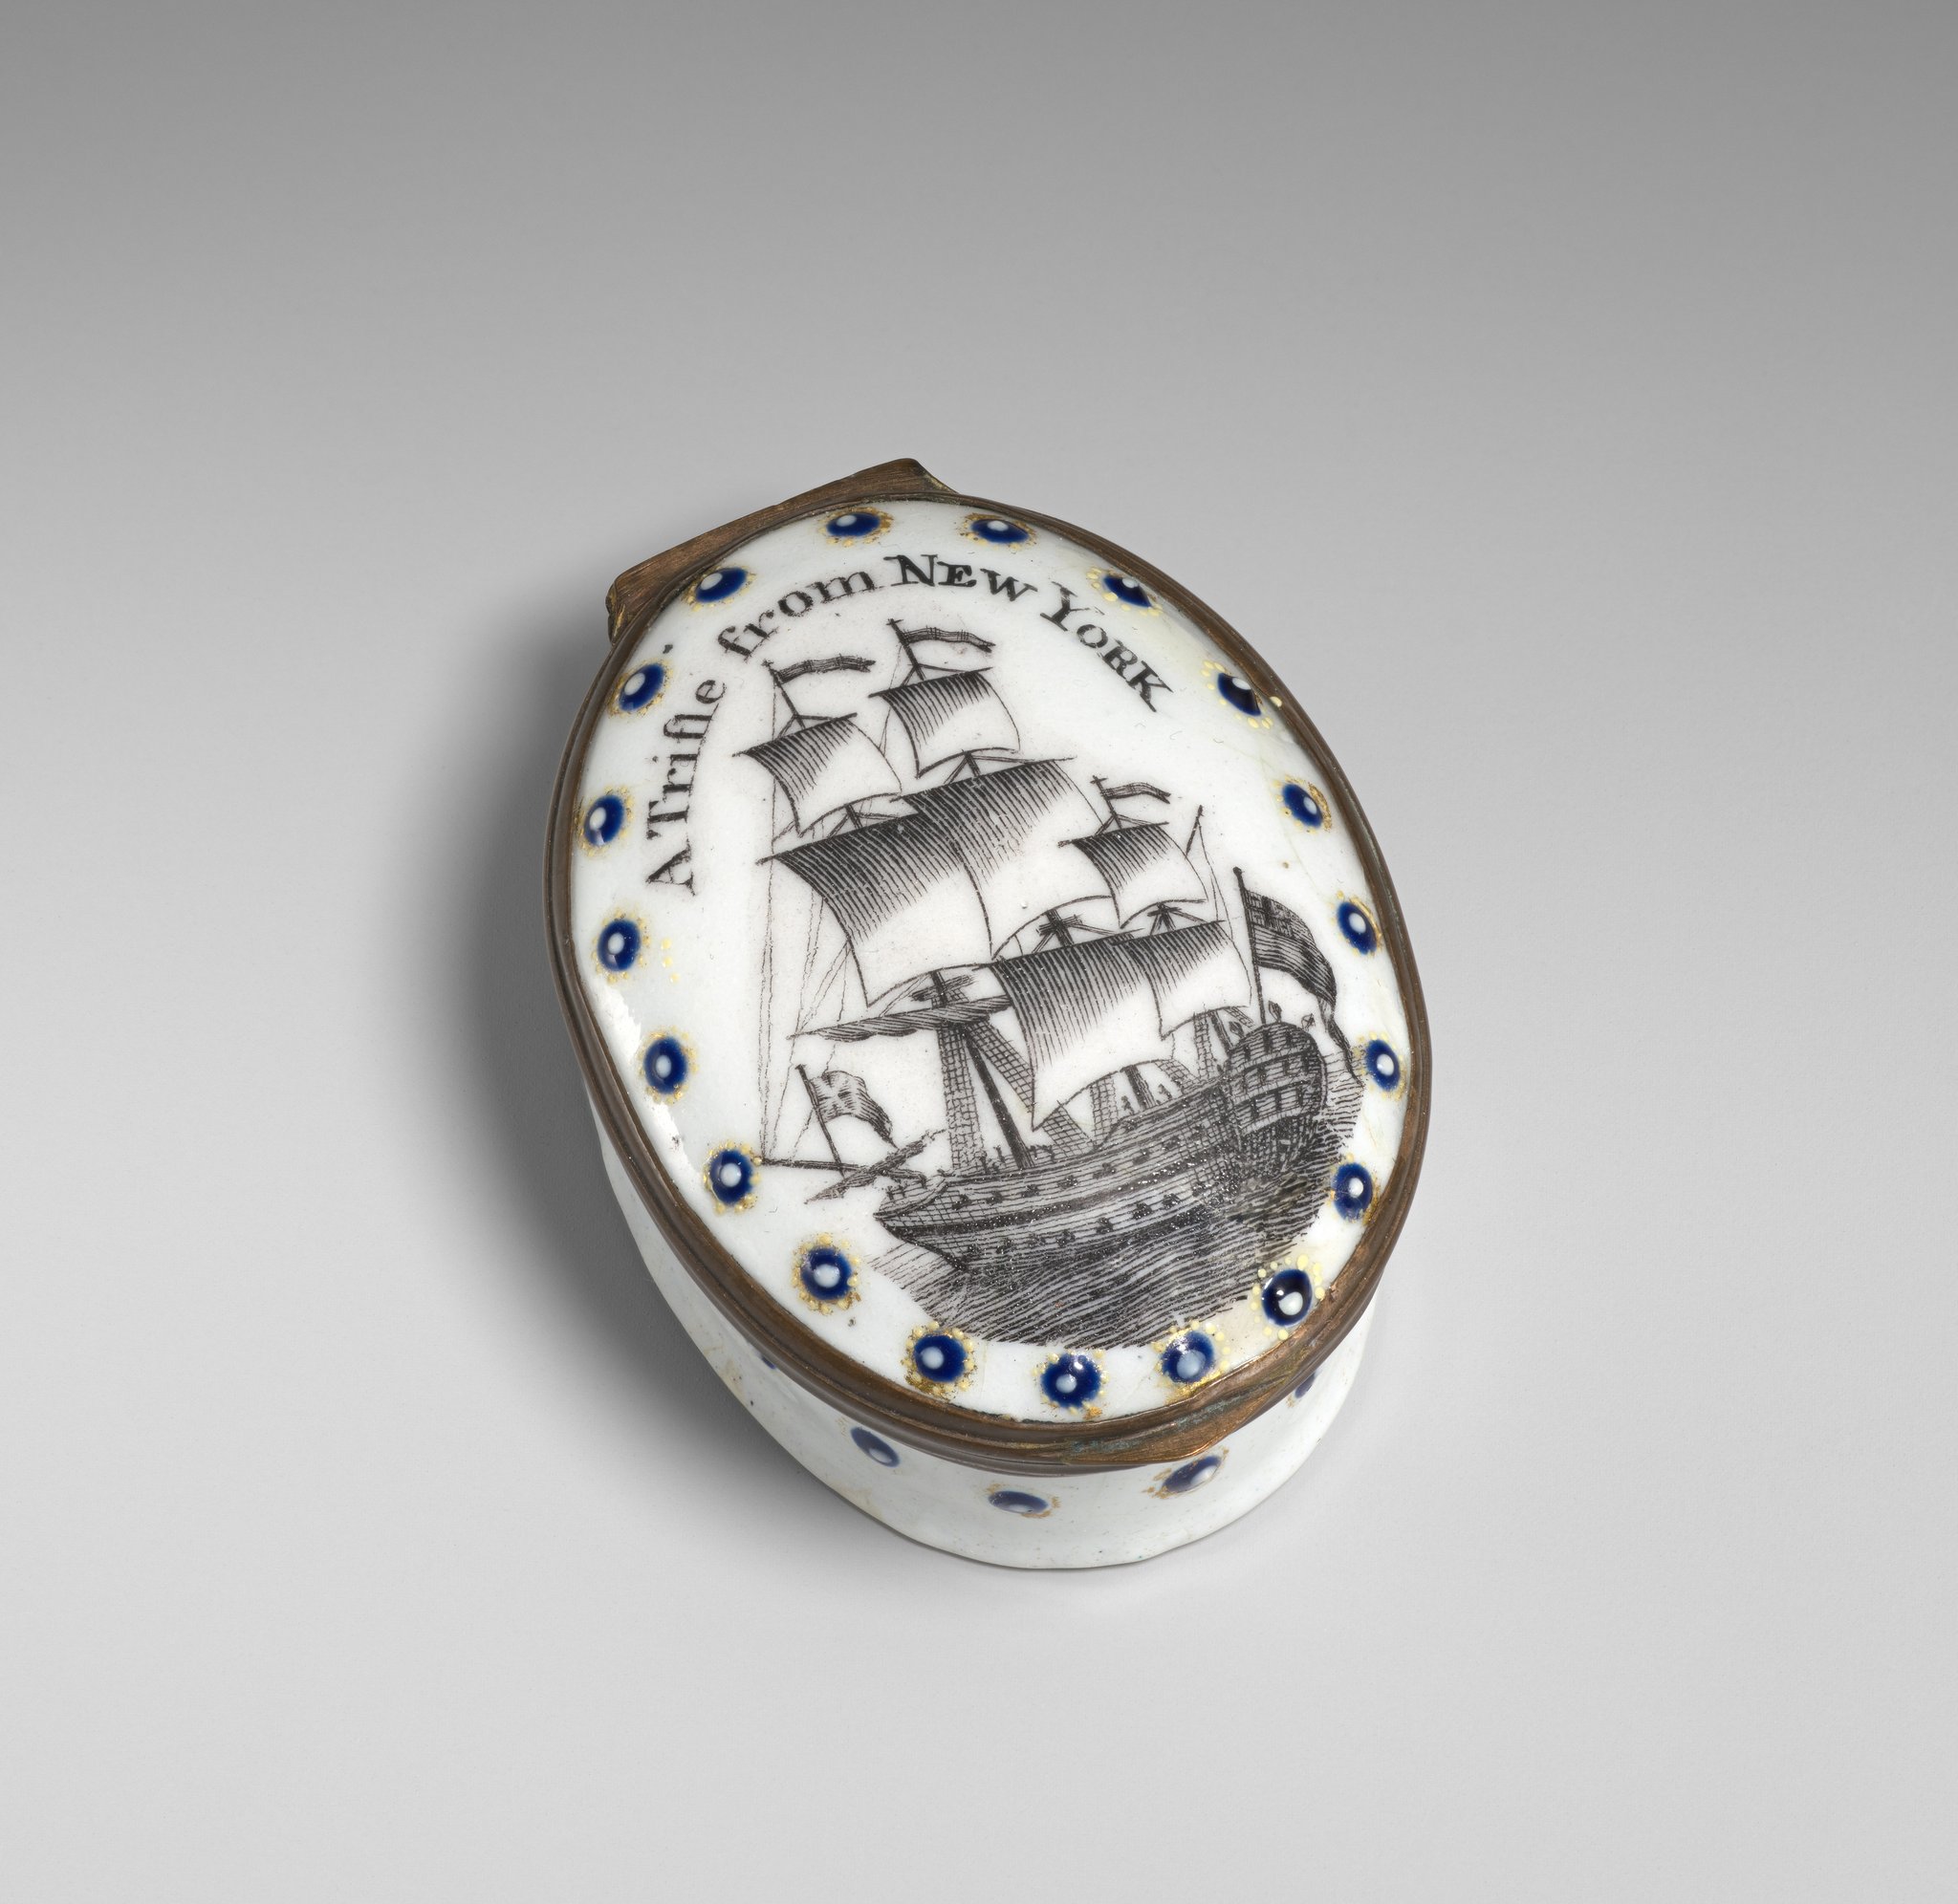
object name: patch box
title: Patch Box "A Trifle from New York"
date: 1780-1790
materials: copper, enamel, glass